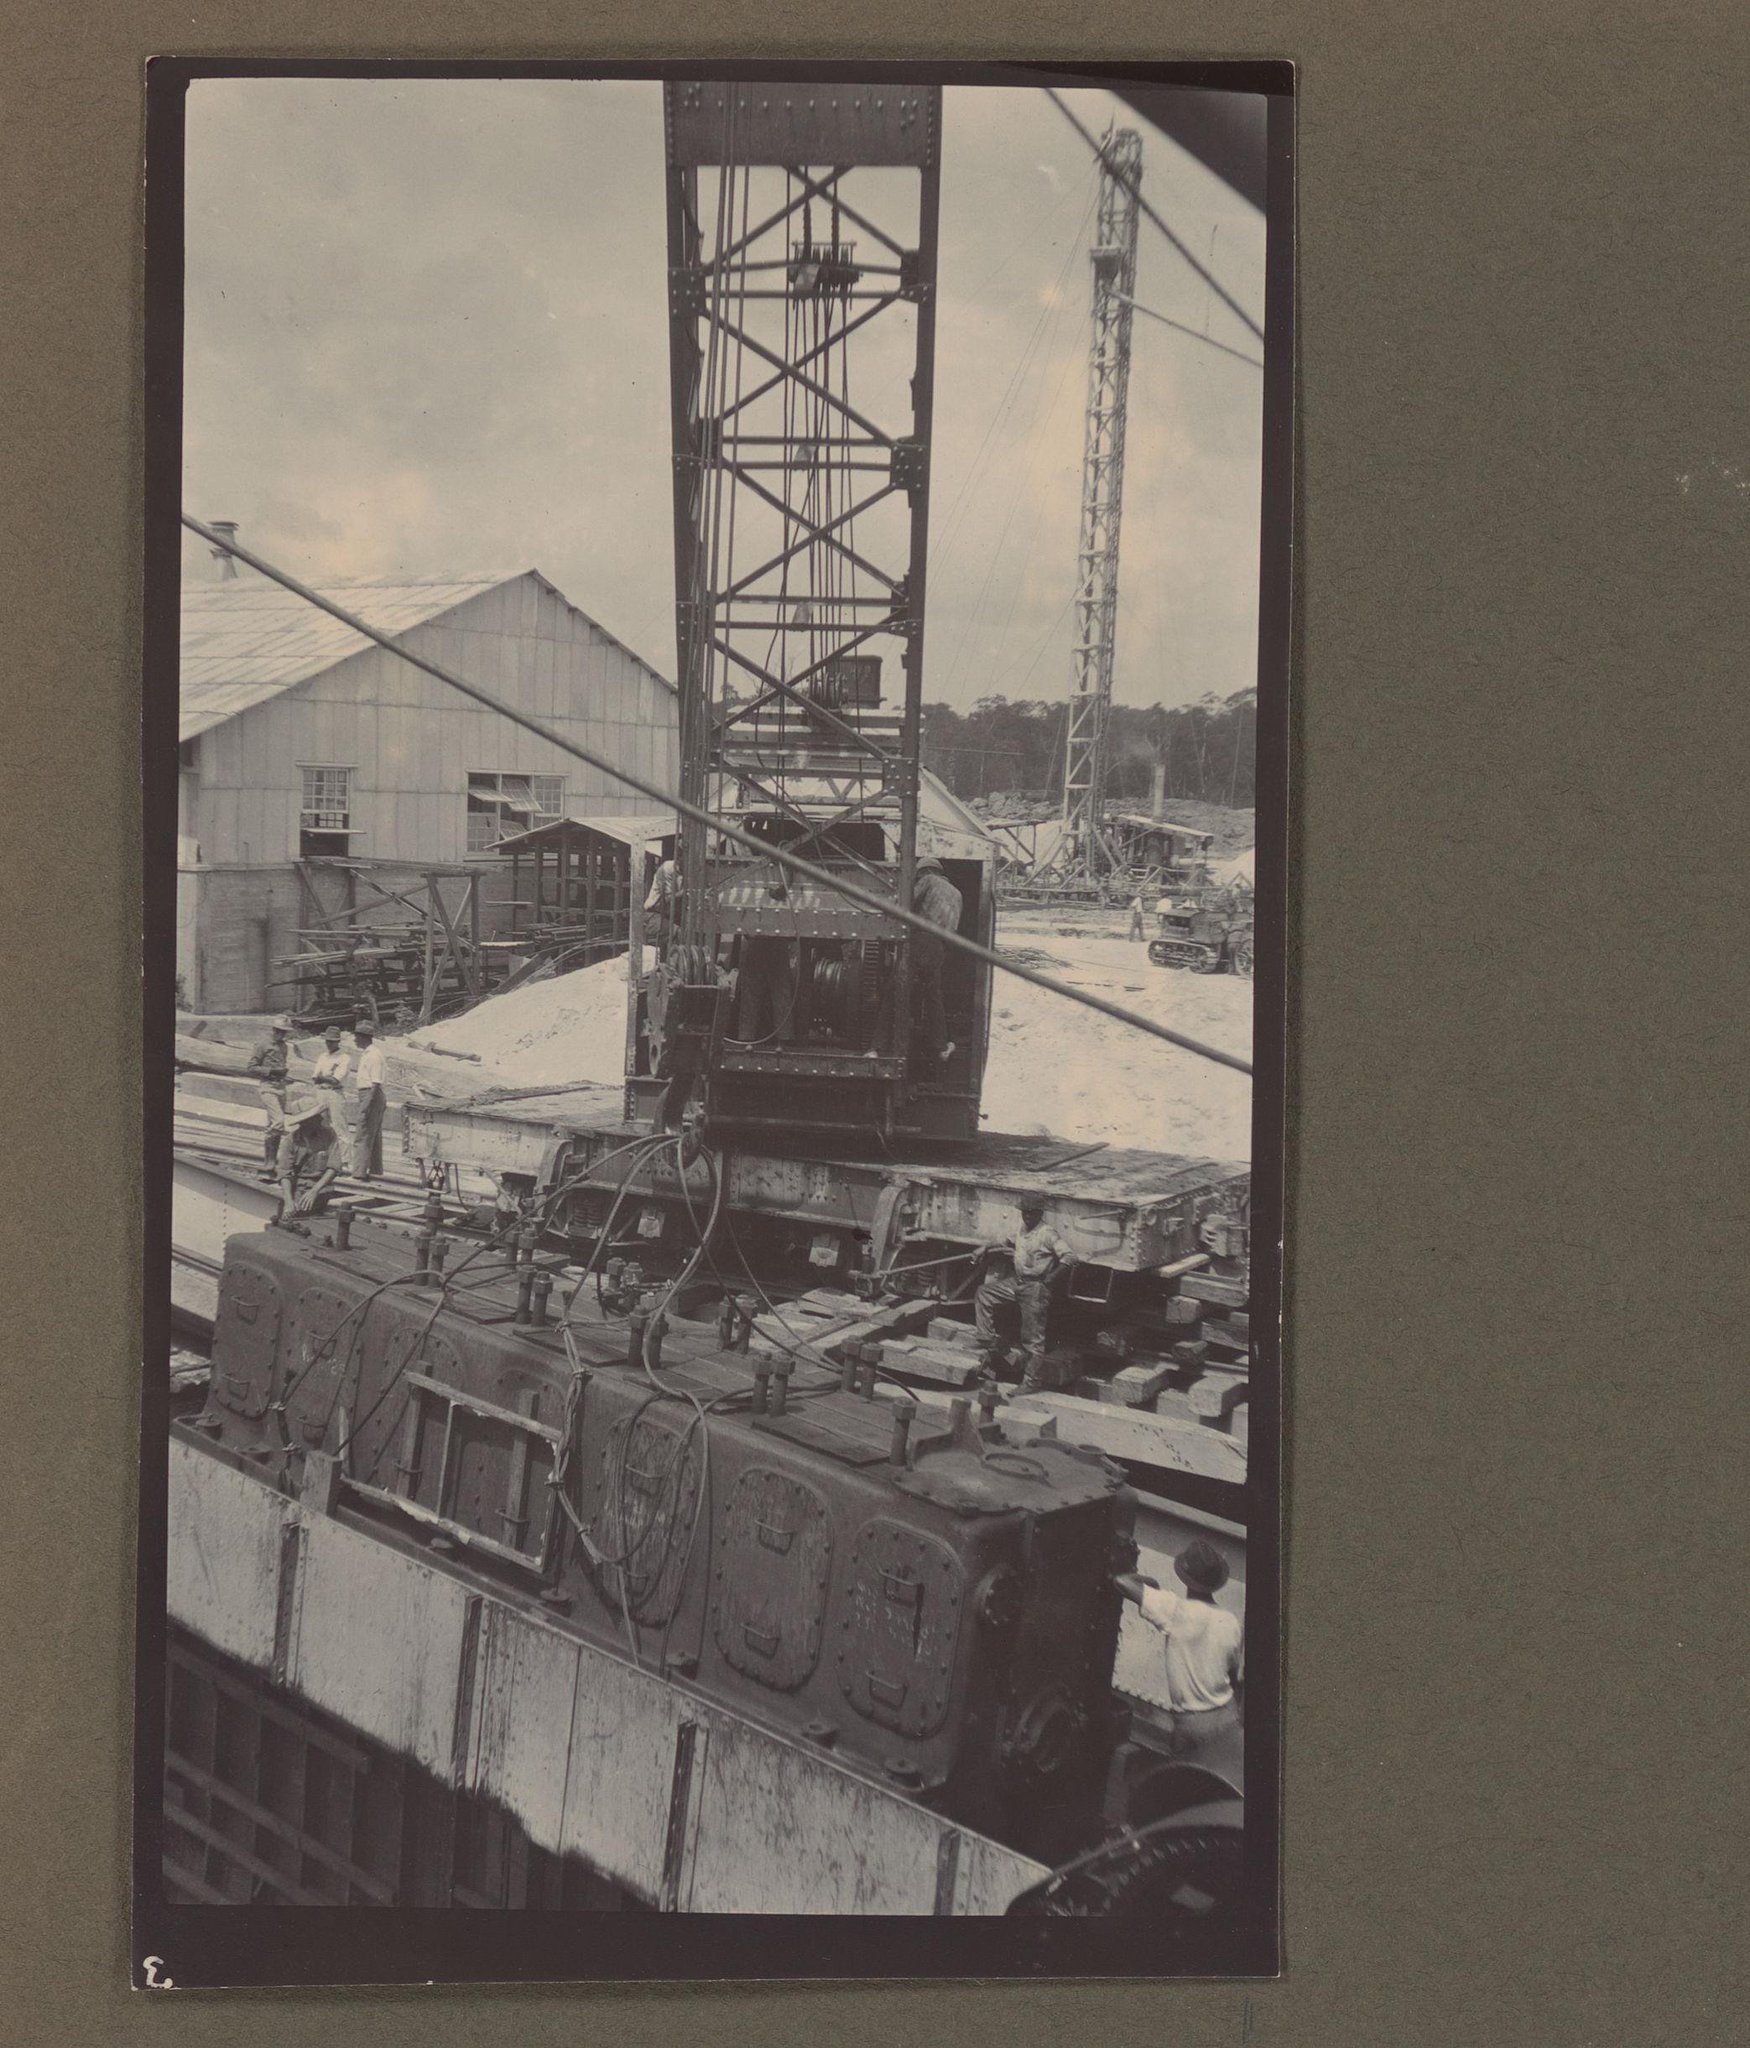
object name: photograph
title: Mijn en fabriek in Moengo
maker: Anonymous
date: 1912-1925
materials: photographic support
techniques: photography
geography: suriname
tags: jetten, familie, moengo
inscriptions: inscription: ‘Dec '25 Unloading 500 HP Dresel crankshaft’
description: Terrein van de mijn en fabriek in Moengo. Foto op een bladzijde van een los albumblad. Onderdeel van het ensemble met foto's van de familie van ingenieur Jetten in de mijnbouwstad Moengo in Suriname.